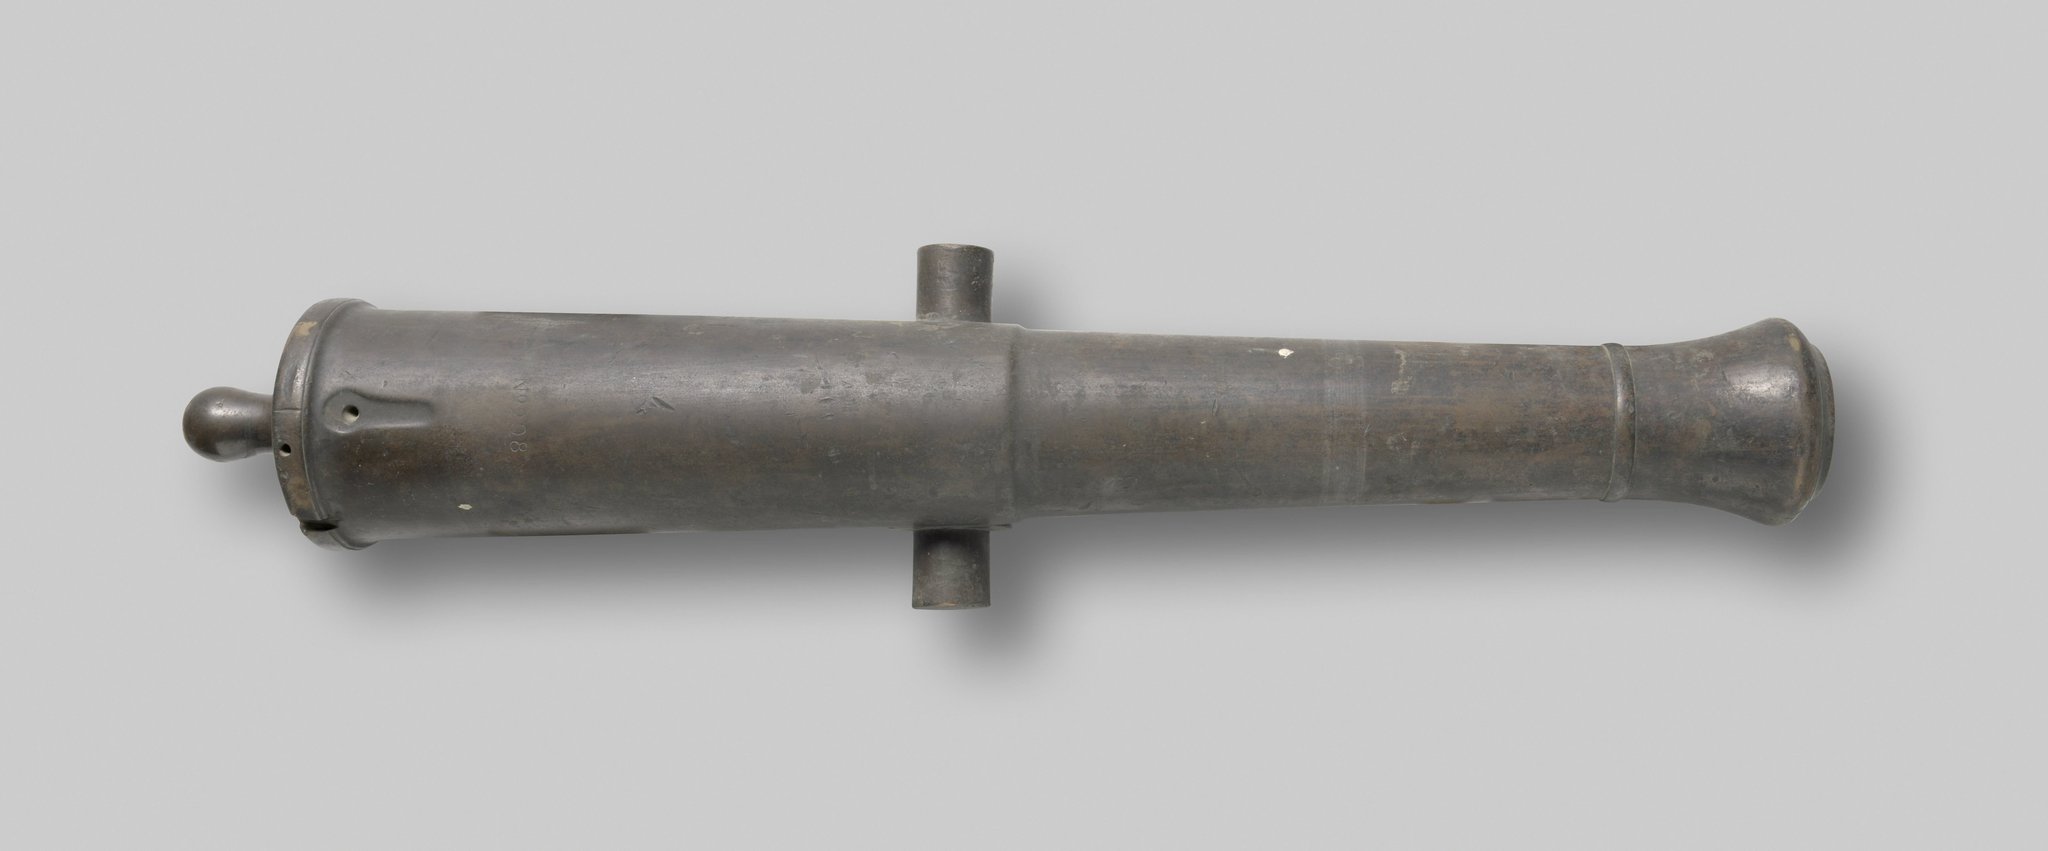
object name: cannon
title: Draaibas n° 298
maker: michel brézin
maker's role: geschutgieter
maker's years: 1758-1828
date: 1812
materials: bronze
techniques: casting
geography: paris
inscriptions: serial number: ‘N° 298’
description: Glad kanon met ronde druif. Kulasband met bovenop een kerf en rond gaatje. Rechts daarvan taps toelopende brede inkeping (1 à 1,5 cm) dwars door de band. Zundgat in peervormige omtrek. Halverwege een breuk en twee galdde tappen. Gladde halsband en iets wijd uitlopende monding. Achterzijde bodemstuk een rond gaatje.